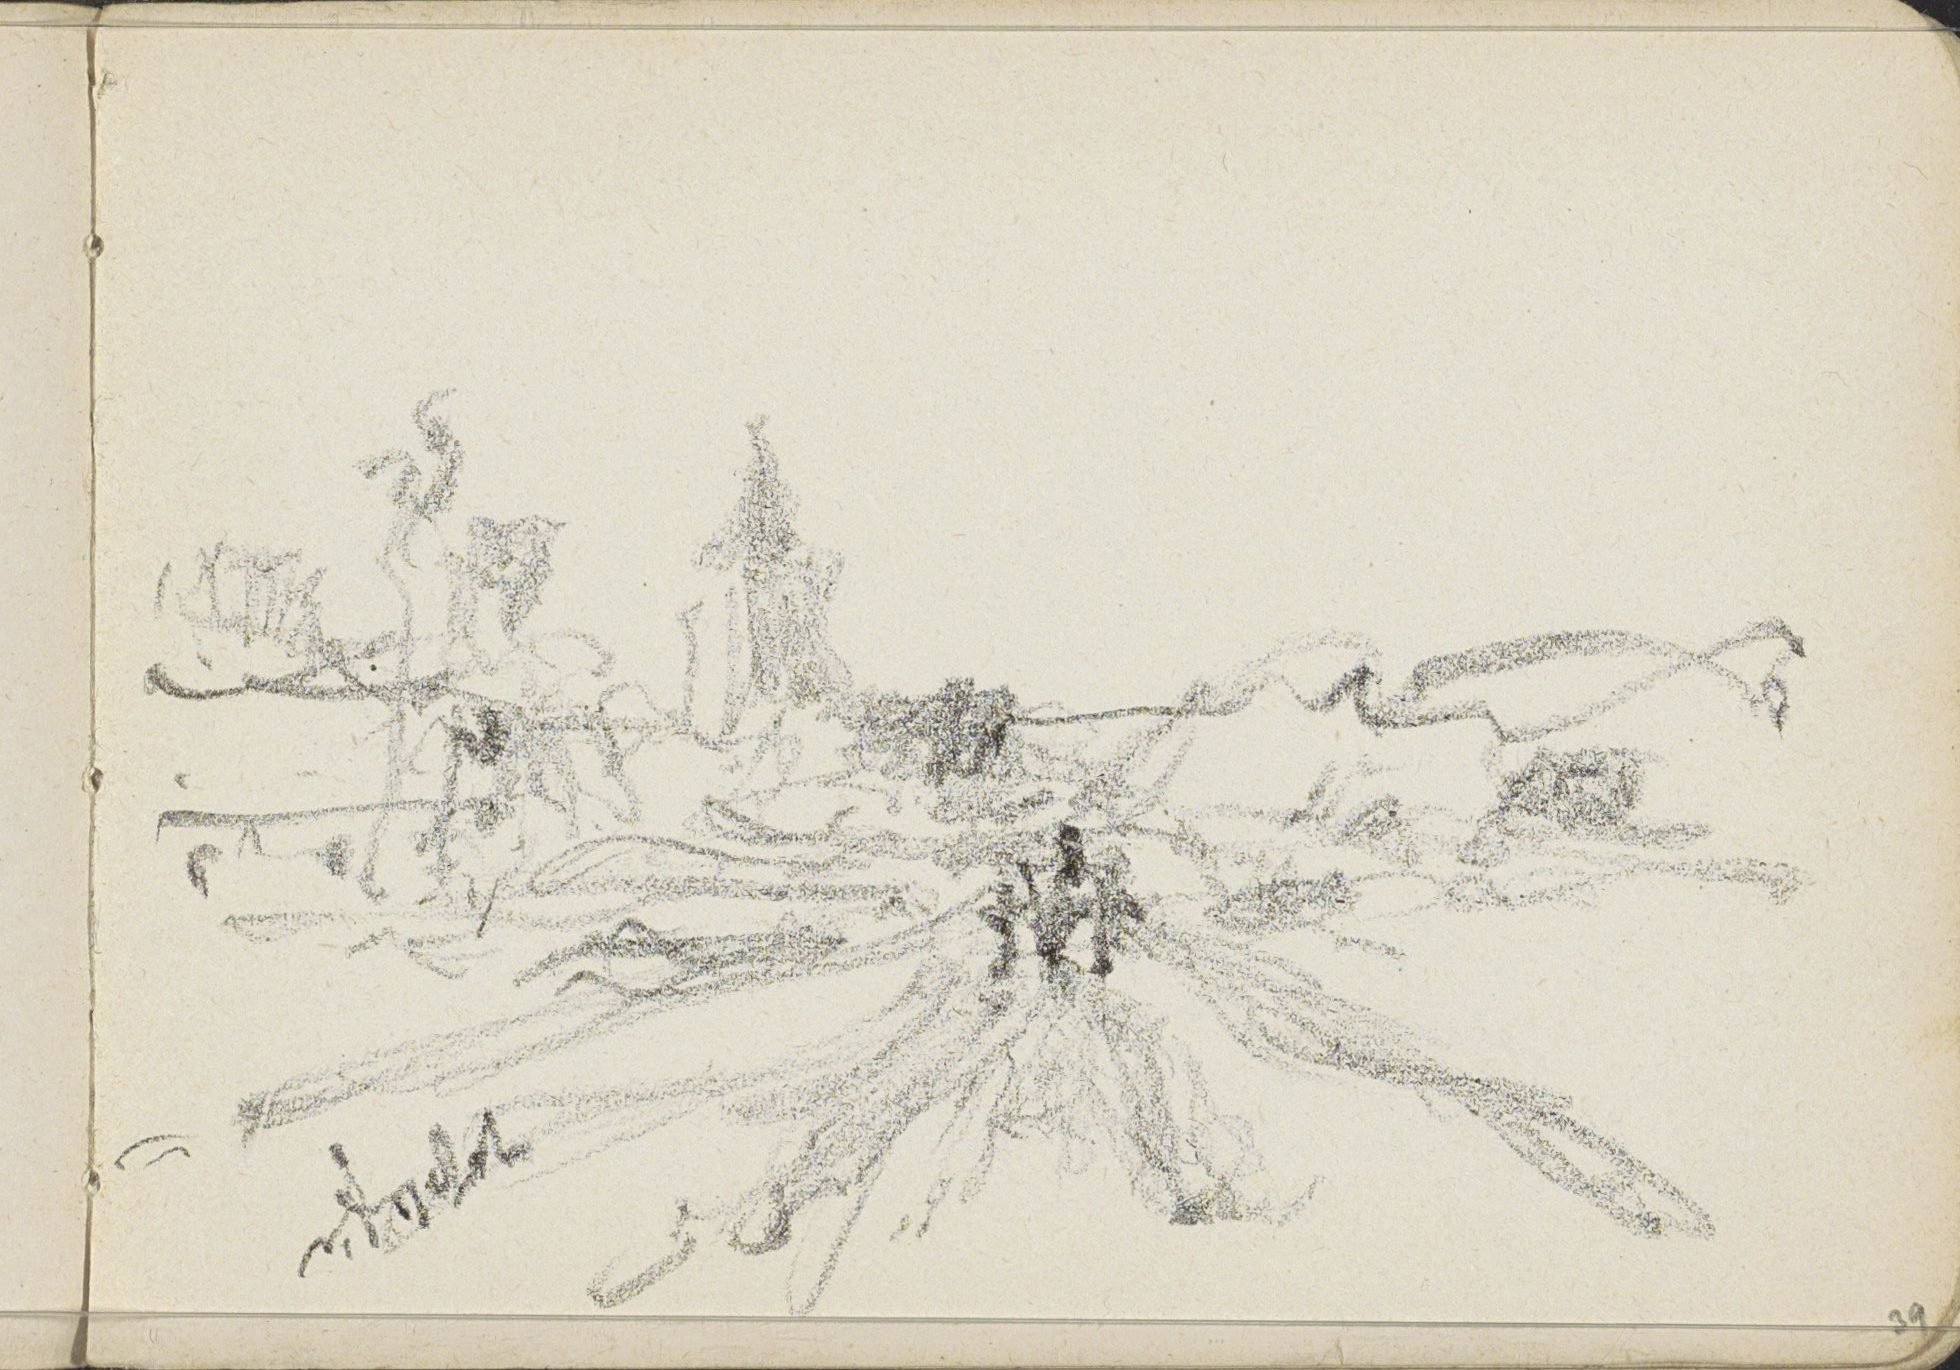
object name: sketchbook leaf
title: Landschap met een kerktoren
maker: willem cornelis rip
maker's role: draughtsman, painter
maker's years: 1856-1922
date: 1905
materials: chalk, paper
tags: city-view, and landscape with man-made constructions, parts of church exterior and annexes: tower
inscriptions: annotation: ‘[...]’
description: Blad 39 recto uit een schetsboek met 42 bladen.